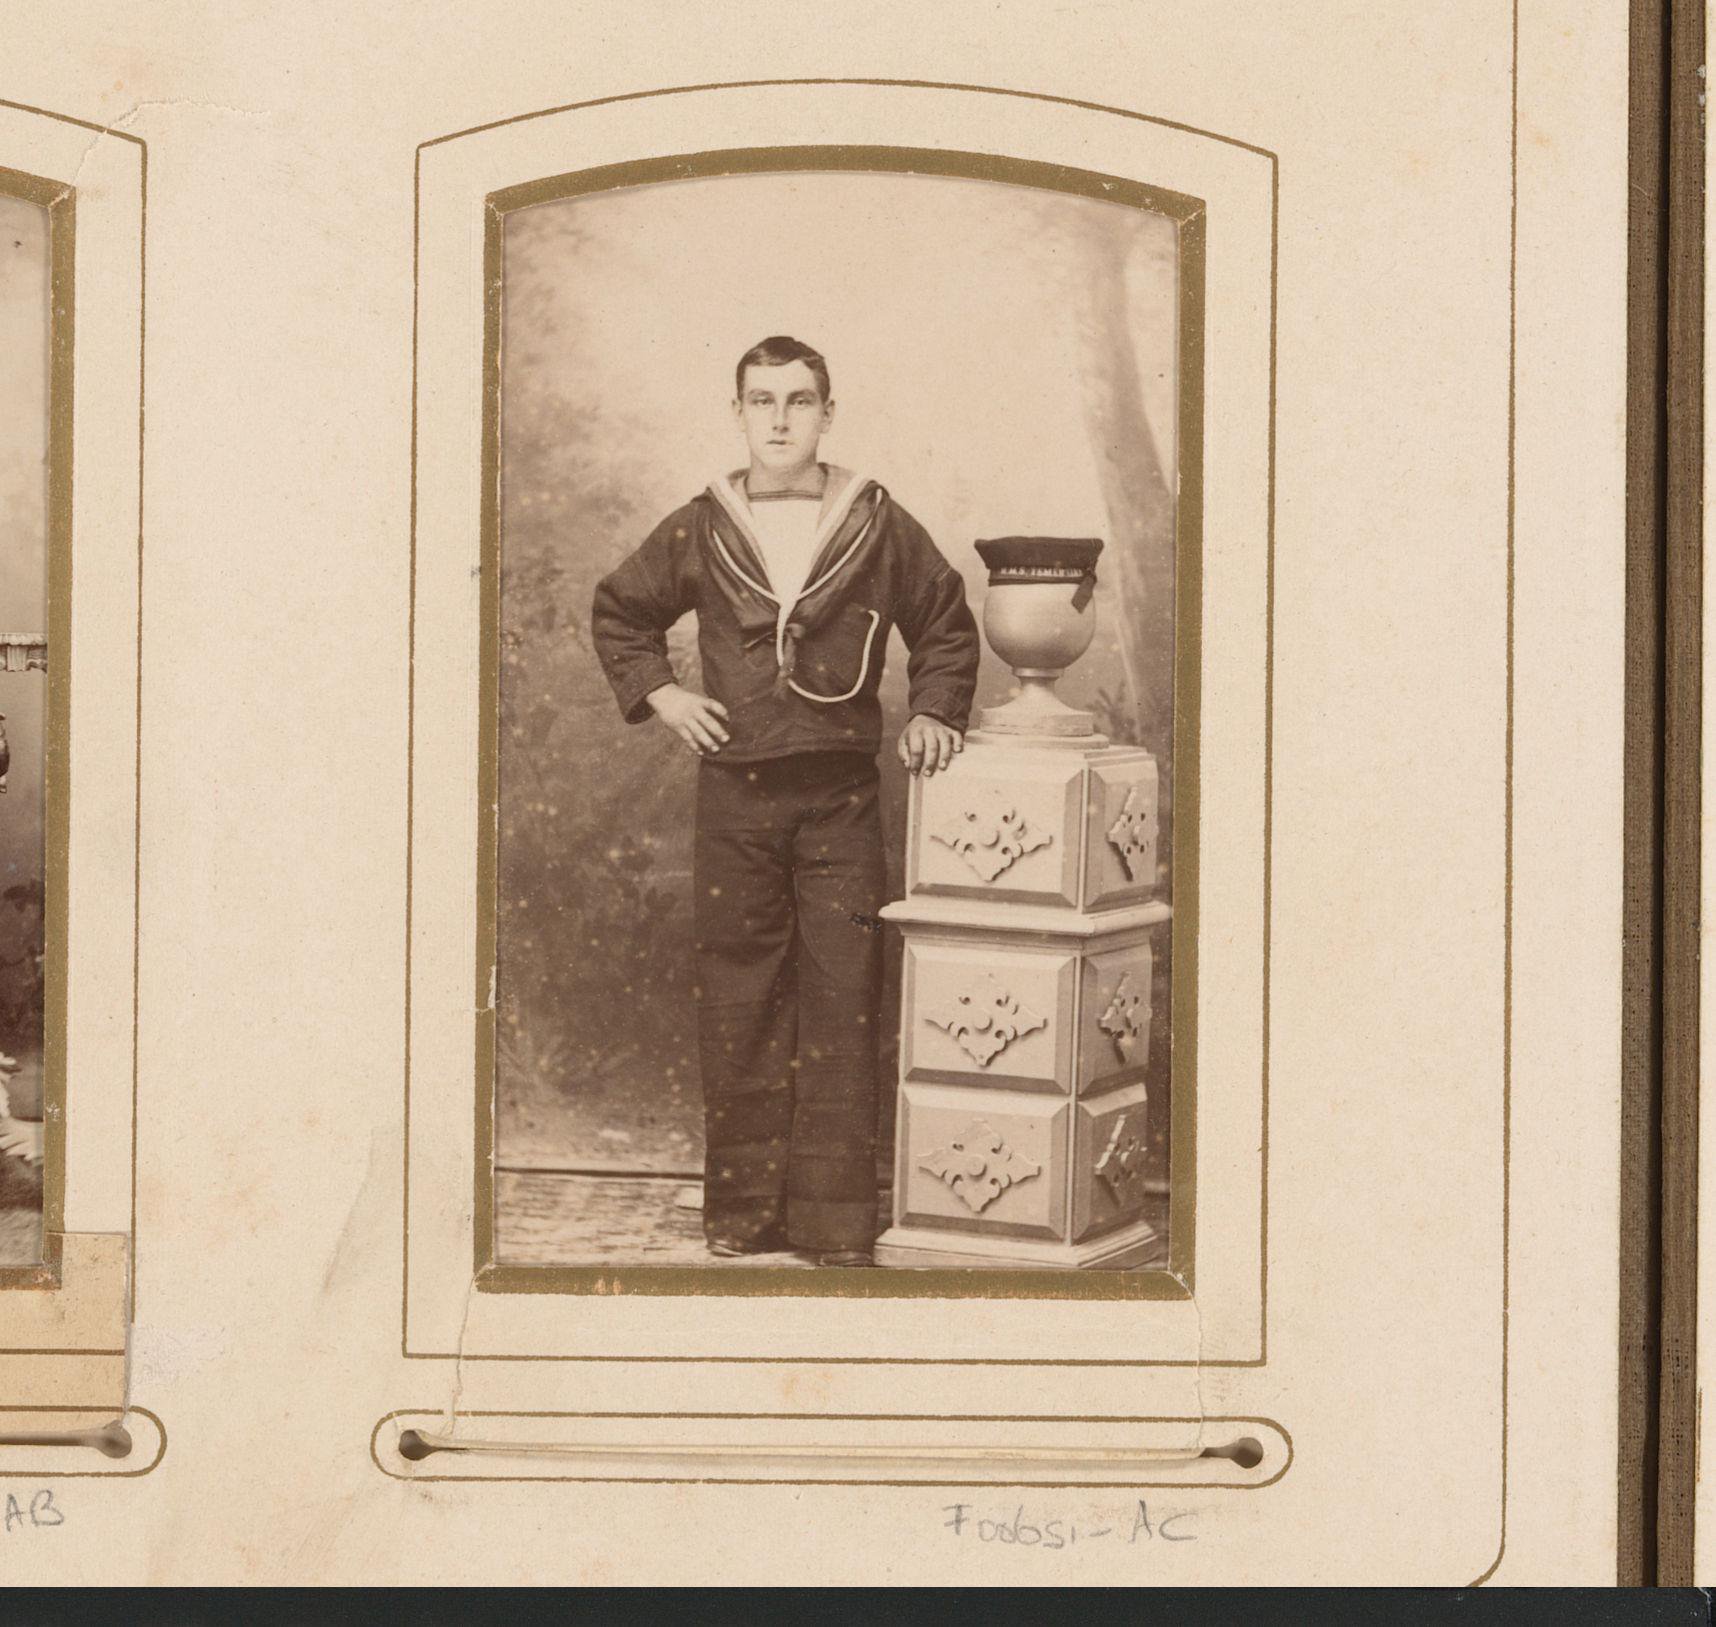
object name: album leaf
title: Portret van een matroos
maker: saverio ciantar preziosi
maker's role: fotograaf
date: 1880-1915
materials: cardboard, photographic support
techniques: albumen print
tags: adult man, historical persons, seaman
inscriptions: inscription: ‘133 Strada Teatro, St George Palace Square, Valletta, Malta’